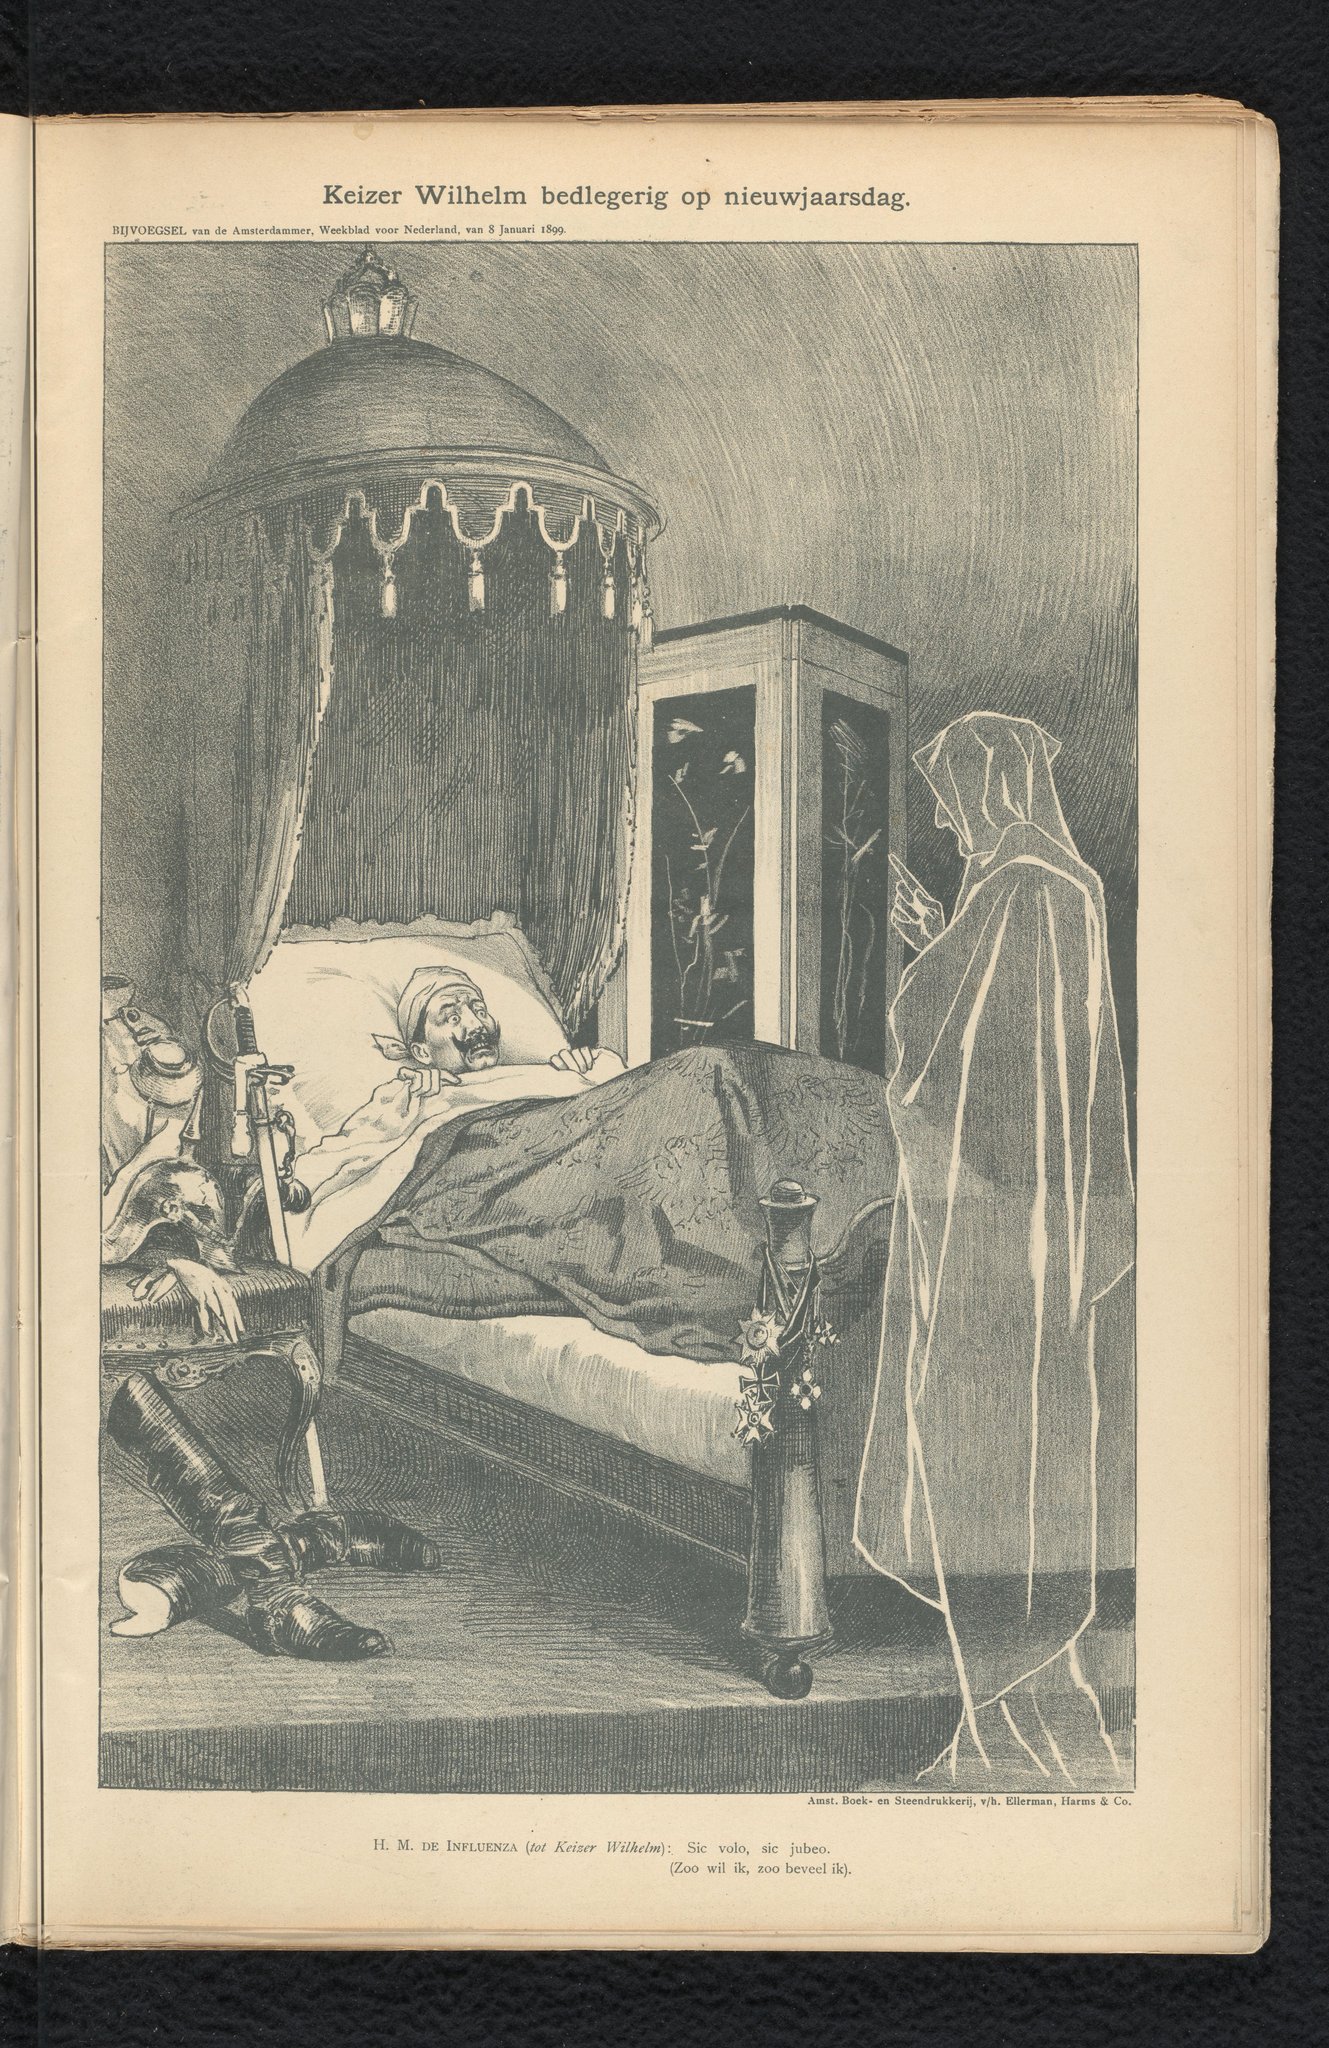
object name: cartoon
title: Keizer Wilhelm bedlegerig op nieuwjaarsdag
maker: johan braakensiek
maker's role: draughtsman, print maker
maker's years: 1858-1940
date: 1899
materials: paper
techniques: lithograph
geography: amsterdam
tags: wilhelm ii (keizer van duitsland), diseases affecting the whole body, patient, sick person, waking up, spirit, ghost, political caricatures and satires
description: Keizer Wilhelm II in bed tot zijn schrik bezocht door de geest van 'H.M. de Infleunza', de griep.